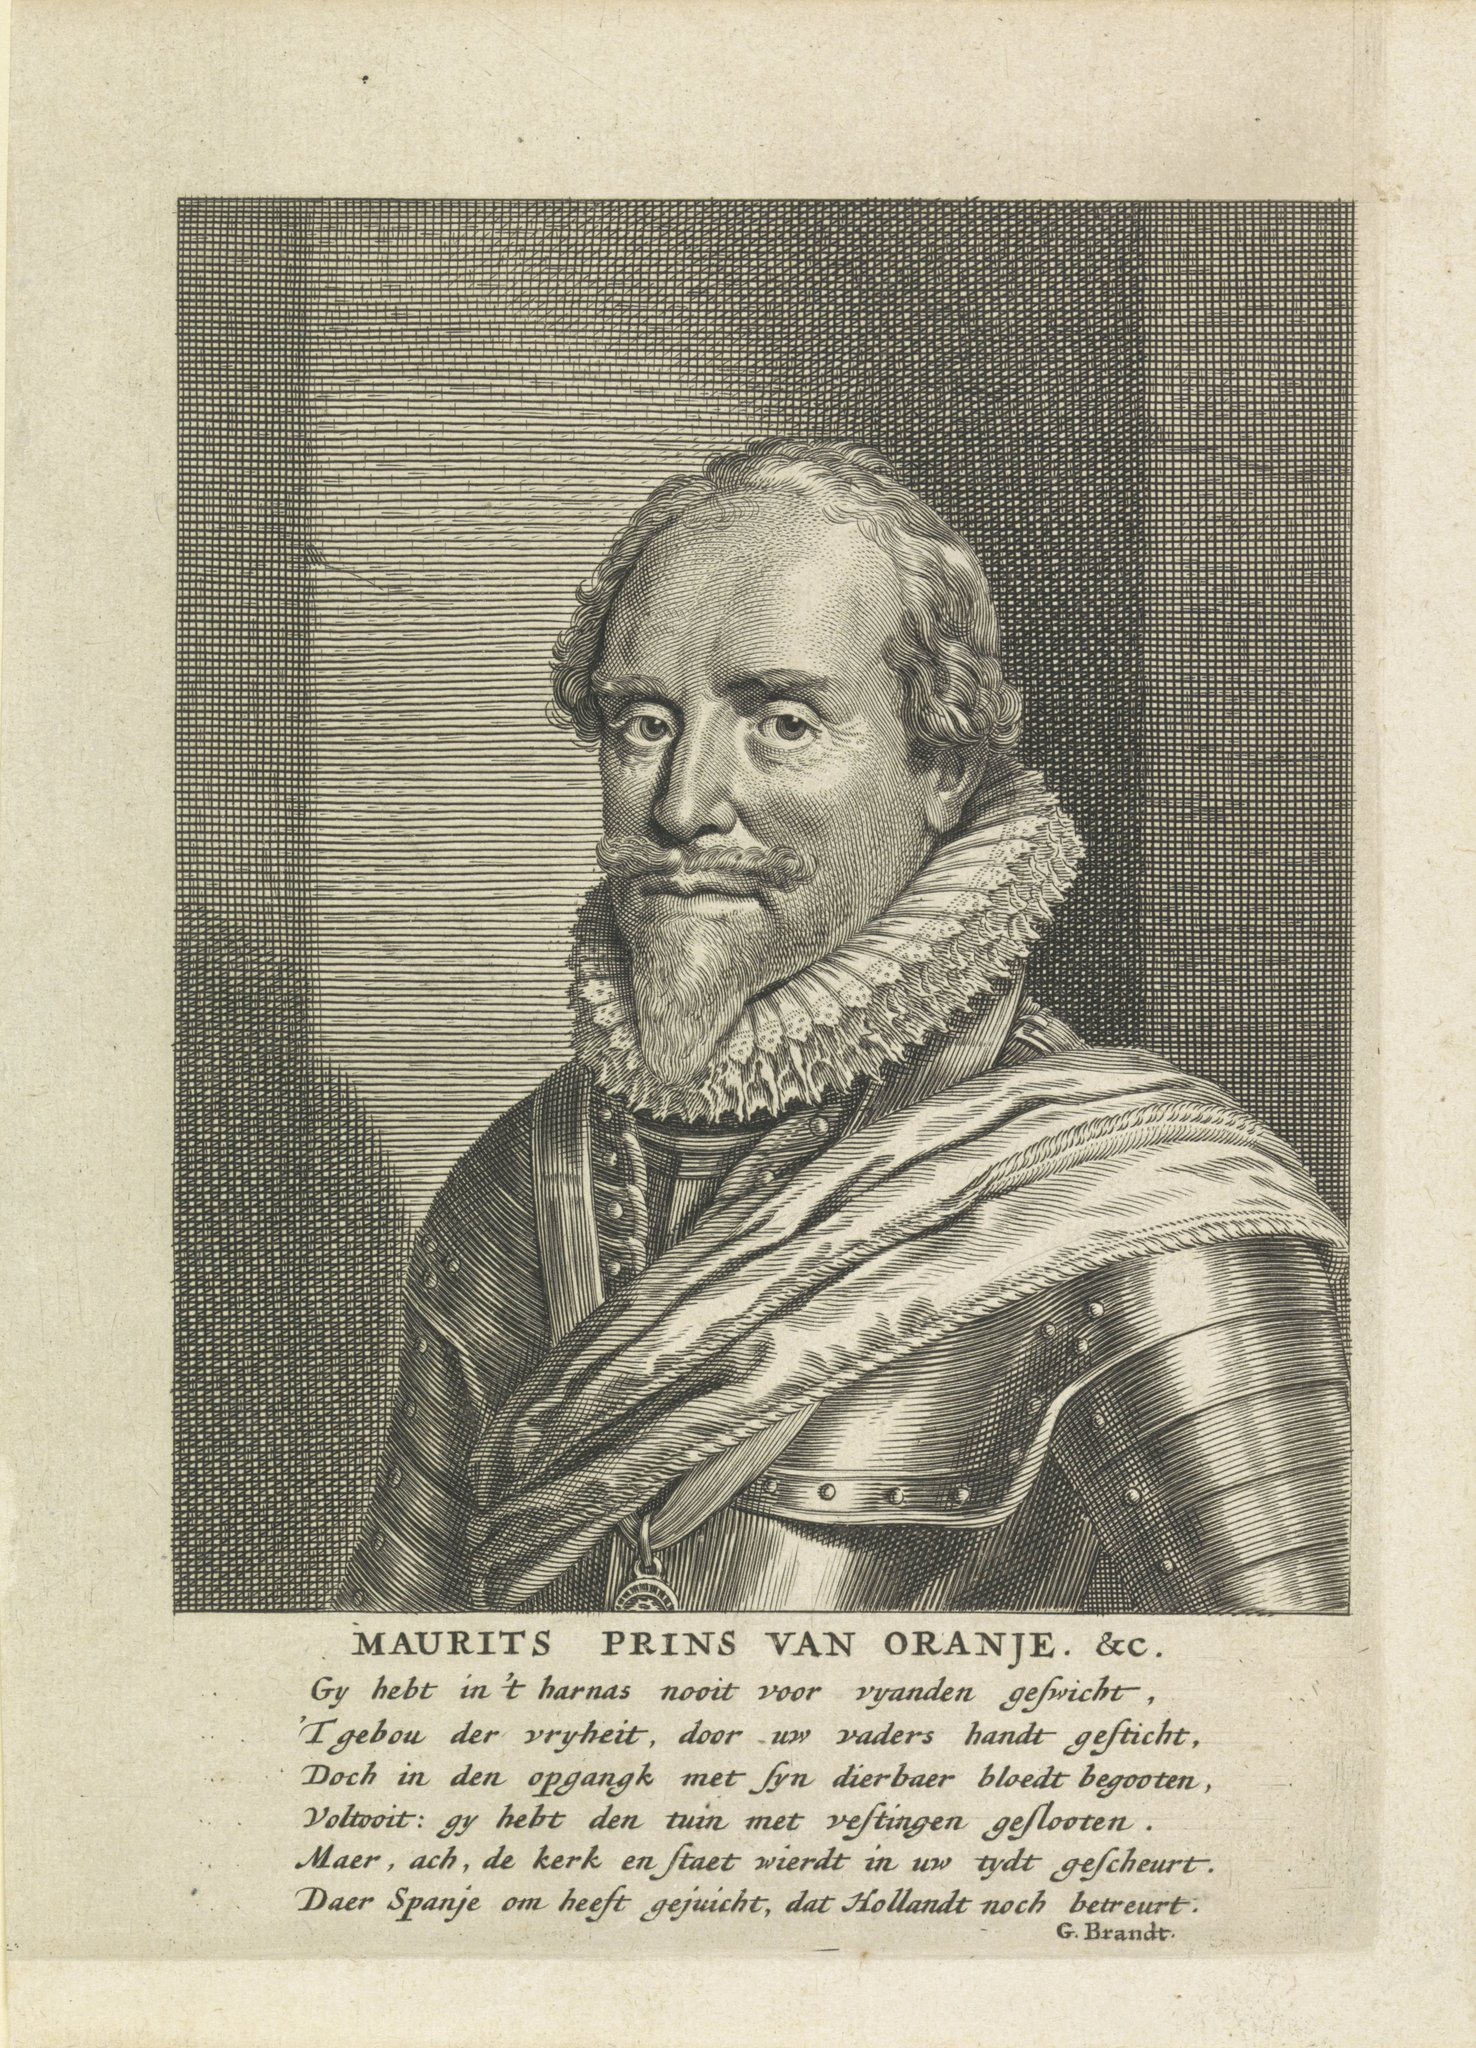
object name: print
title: Portret van Maurits, prins van Oranje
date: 1600-1699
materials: paper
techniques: engraving, etching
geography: low countries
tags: the hague, maurice (prince of orange), knighthood order (garter) - insignia of a knighthood order, e.g.: badge, chain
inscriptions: collector's mark: Lugt 963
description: De hier vermelde titel verwijst naar de hoogst verkregen titel van de geportretteerde, niet per se naar de titel die de geportretteerde op deze voorstelling draagt.